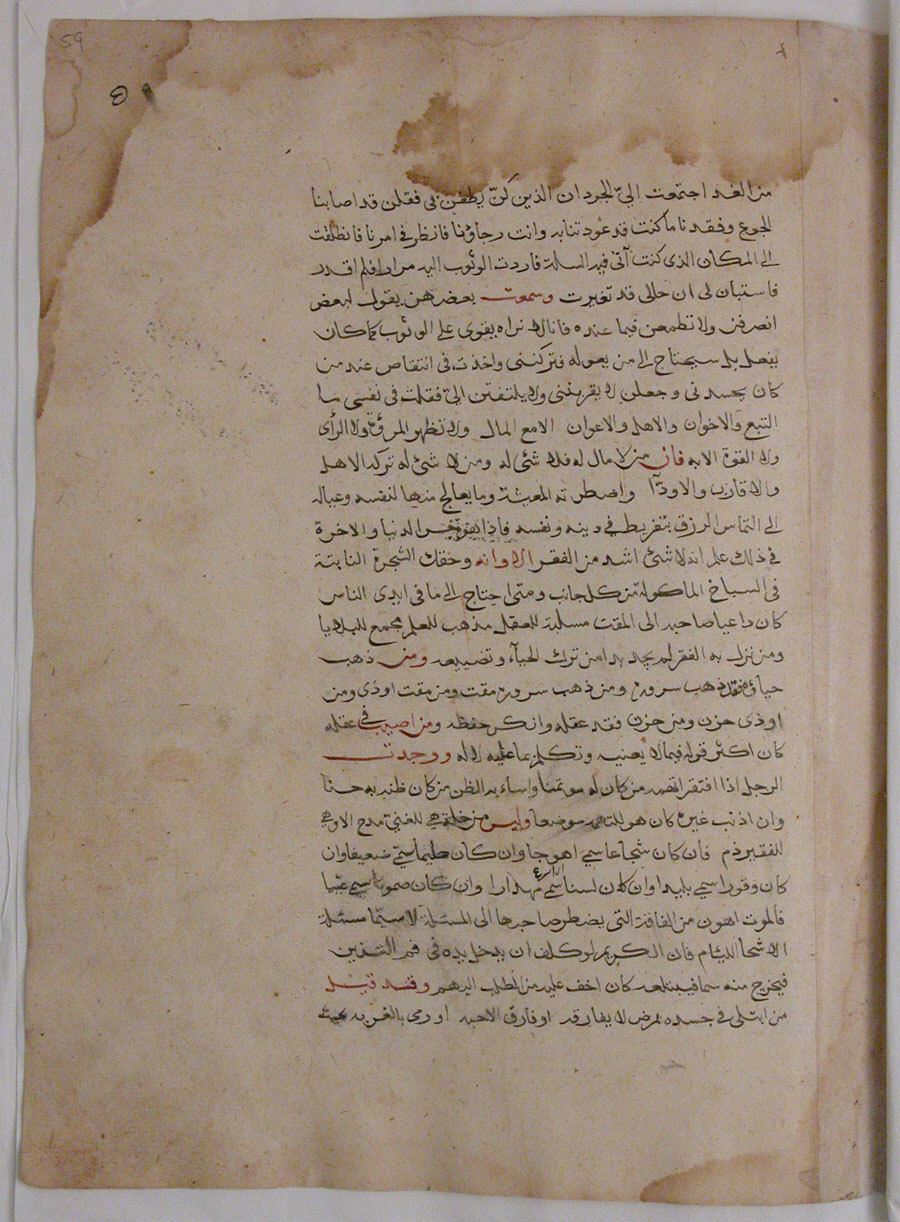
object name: folio from an illustrated manuscript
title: Page of Calligraphy from a Kalila wa Dimna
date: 1526-1550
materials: ink, paper, watercolor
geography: india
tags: arabic,calligraphy